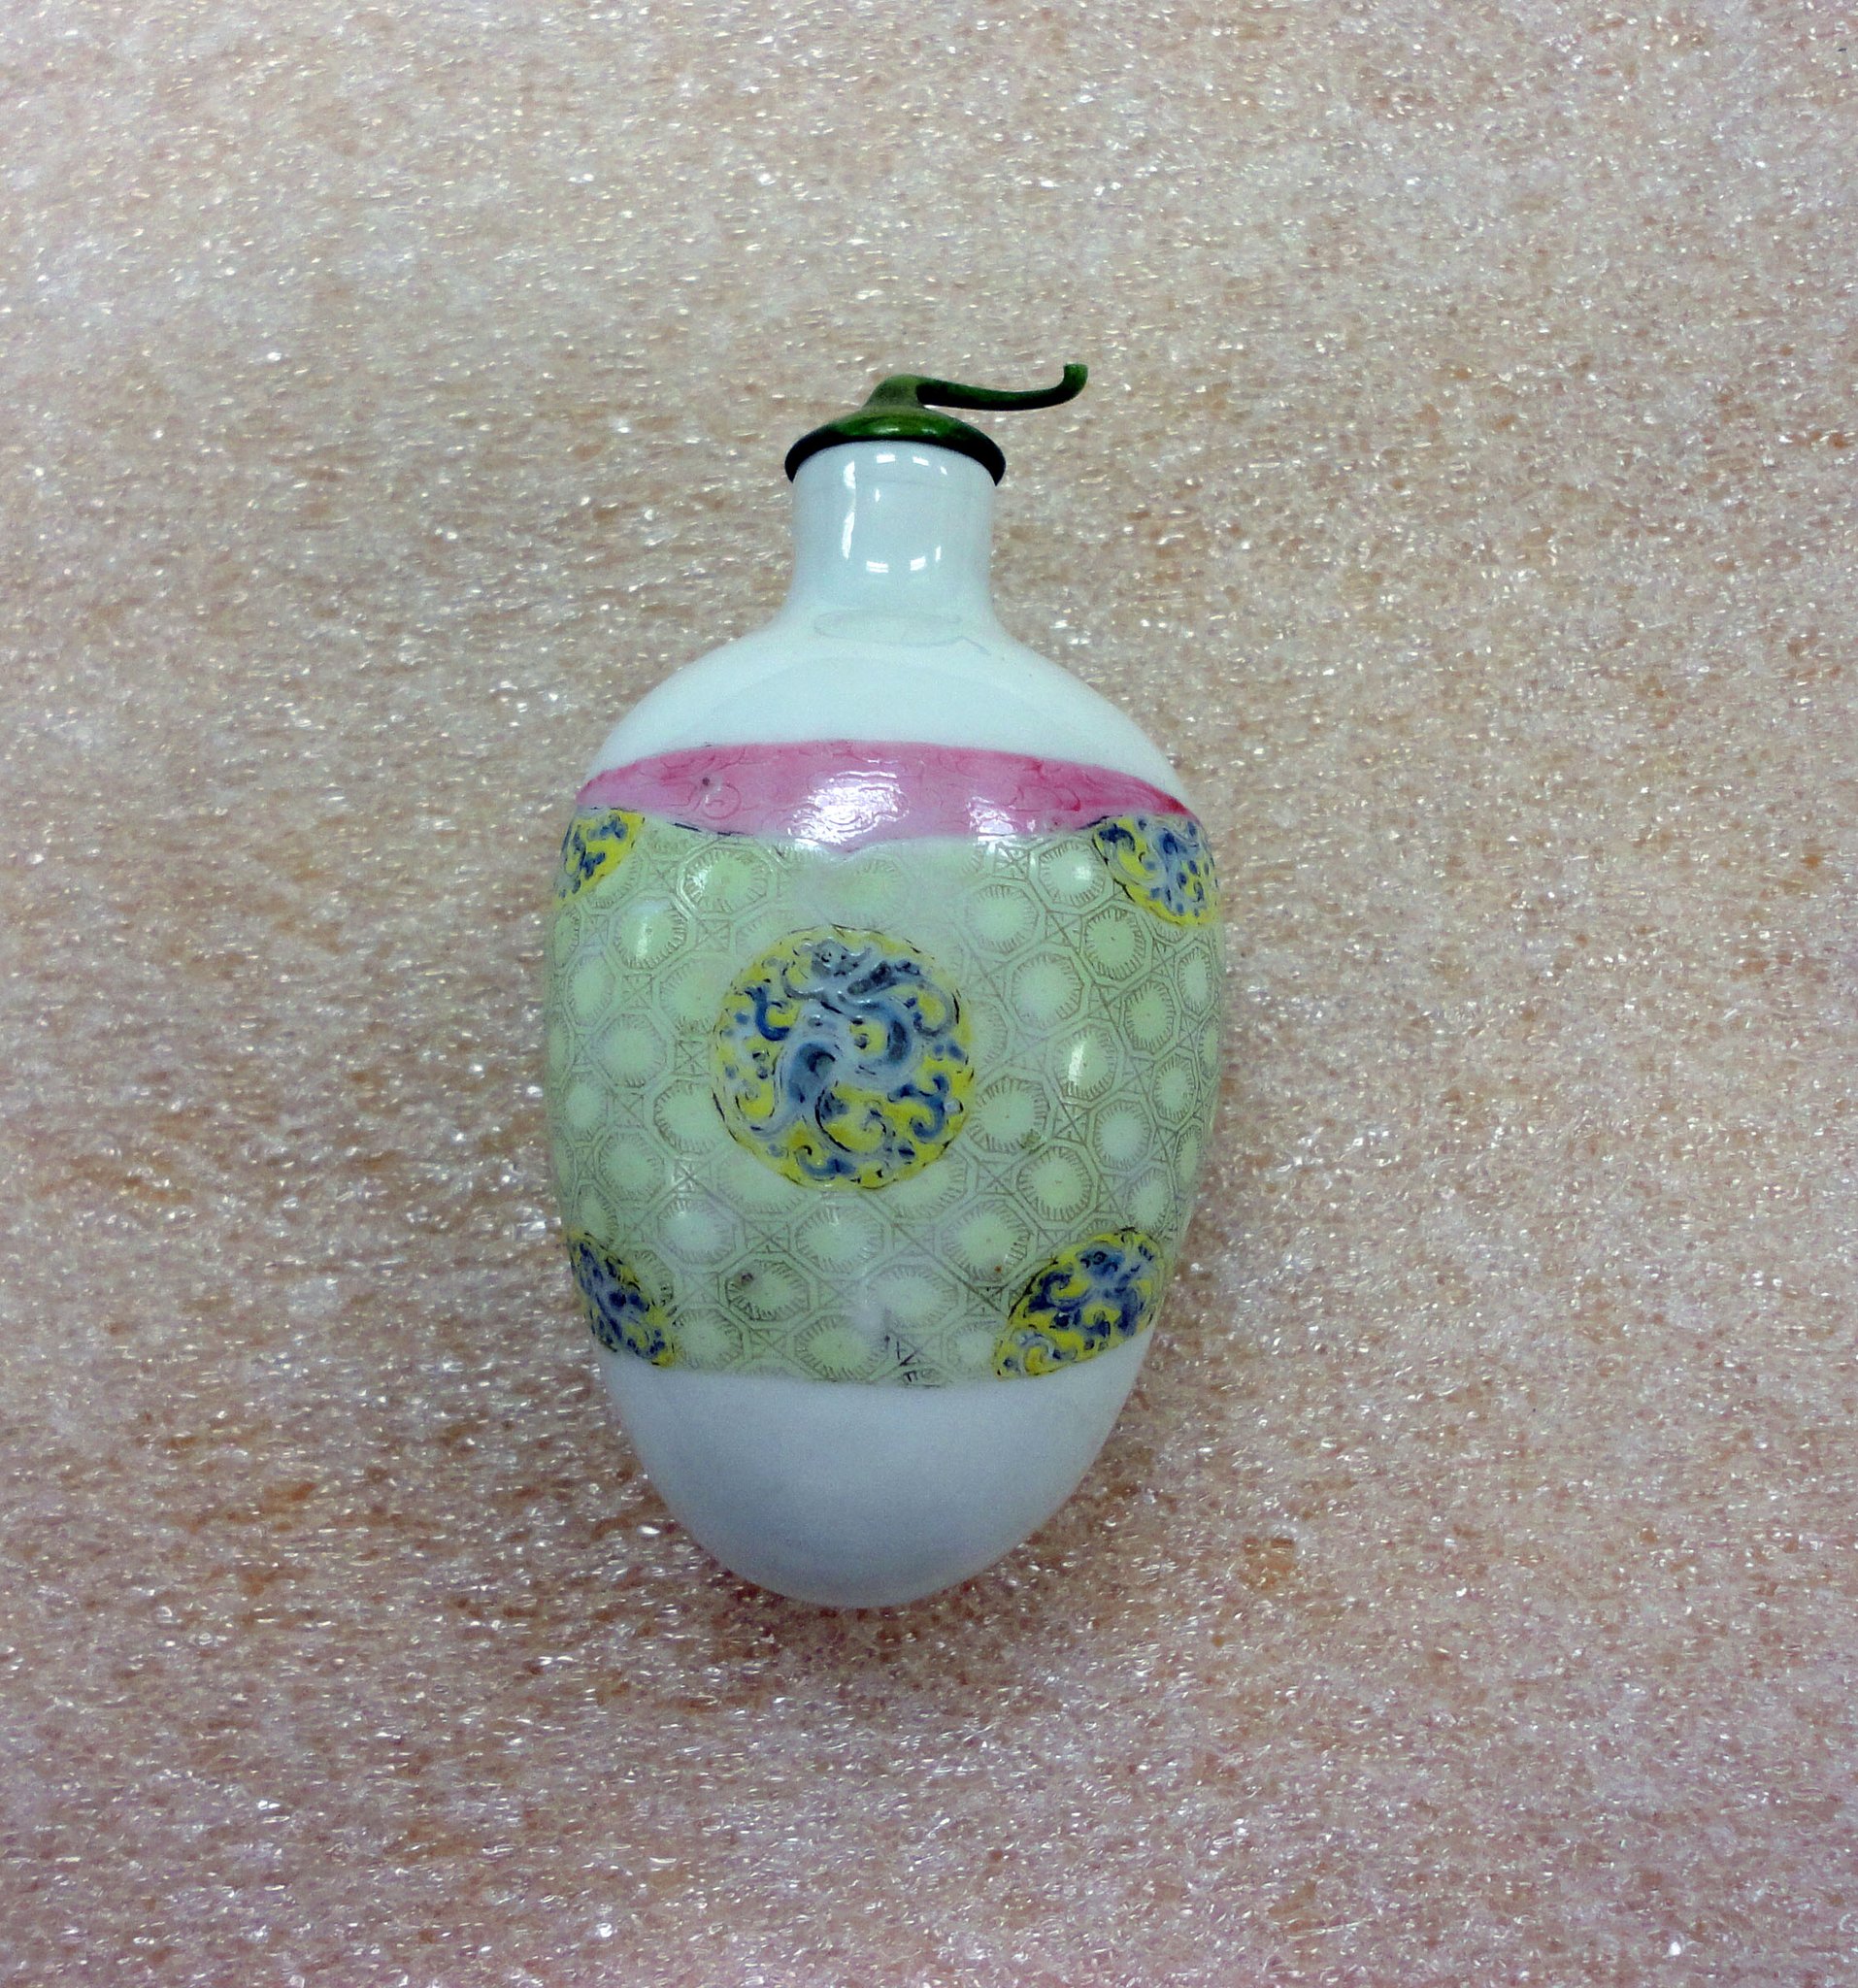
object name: snuff bottle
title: Snuff Bottle with Design of Parcel Wrapper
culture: chinese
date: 1767-1800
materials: enamel, porcelain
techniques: overglaze